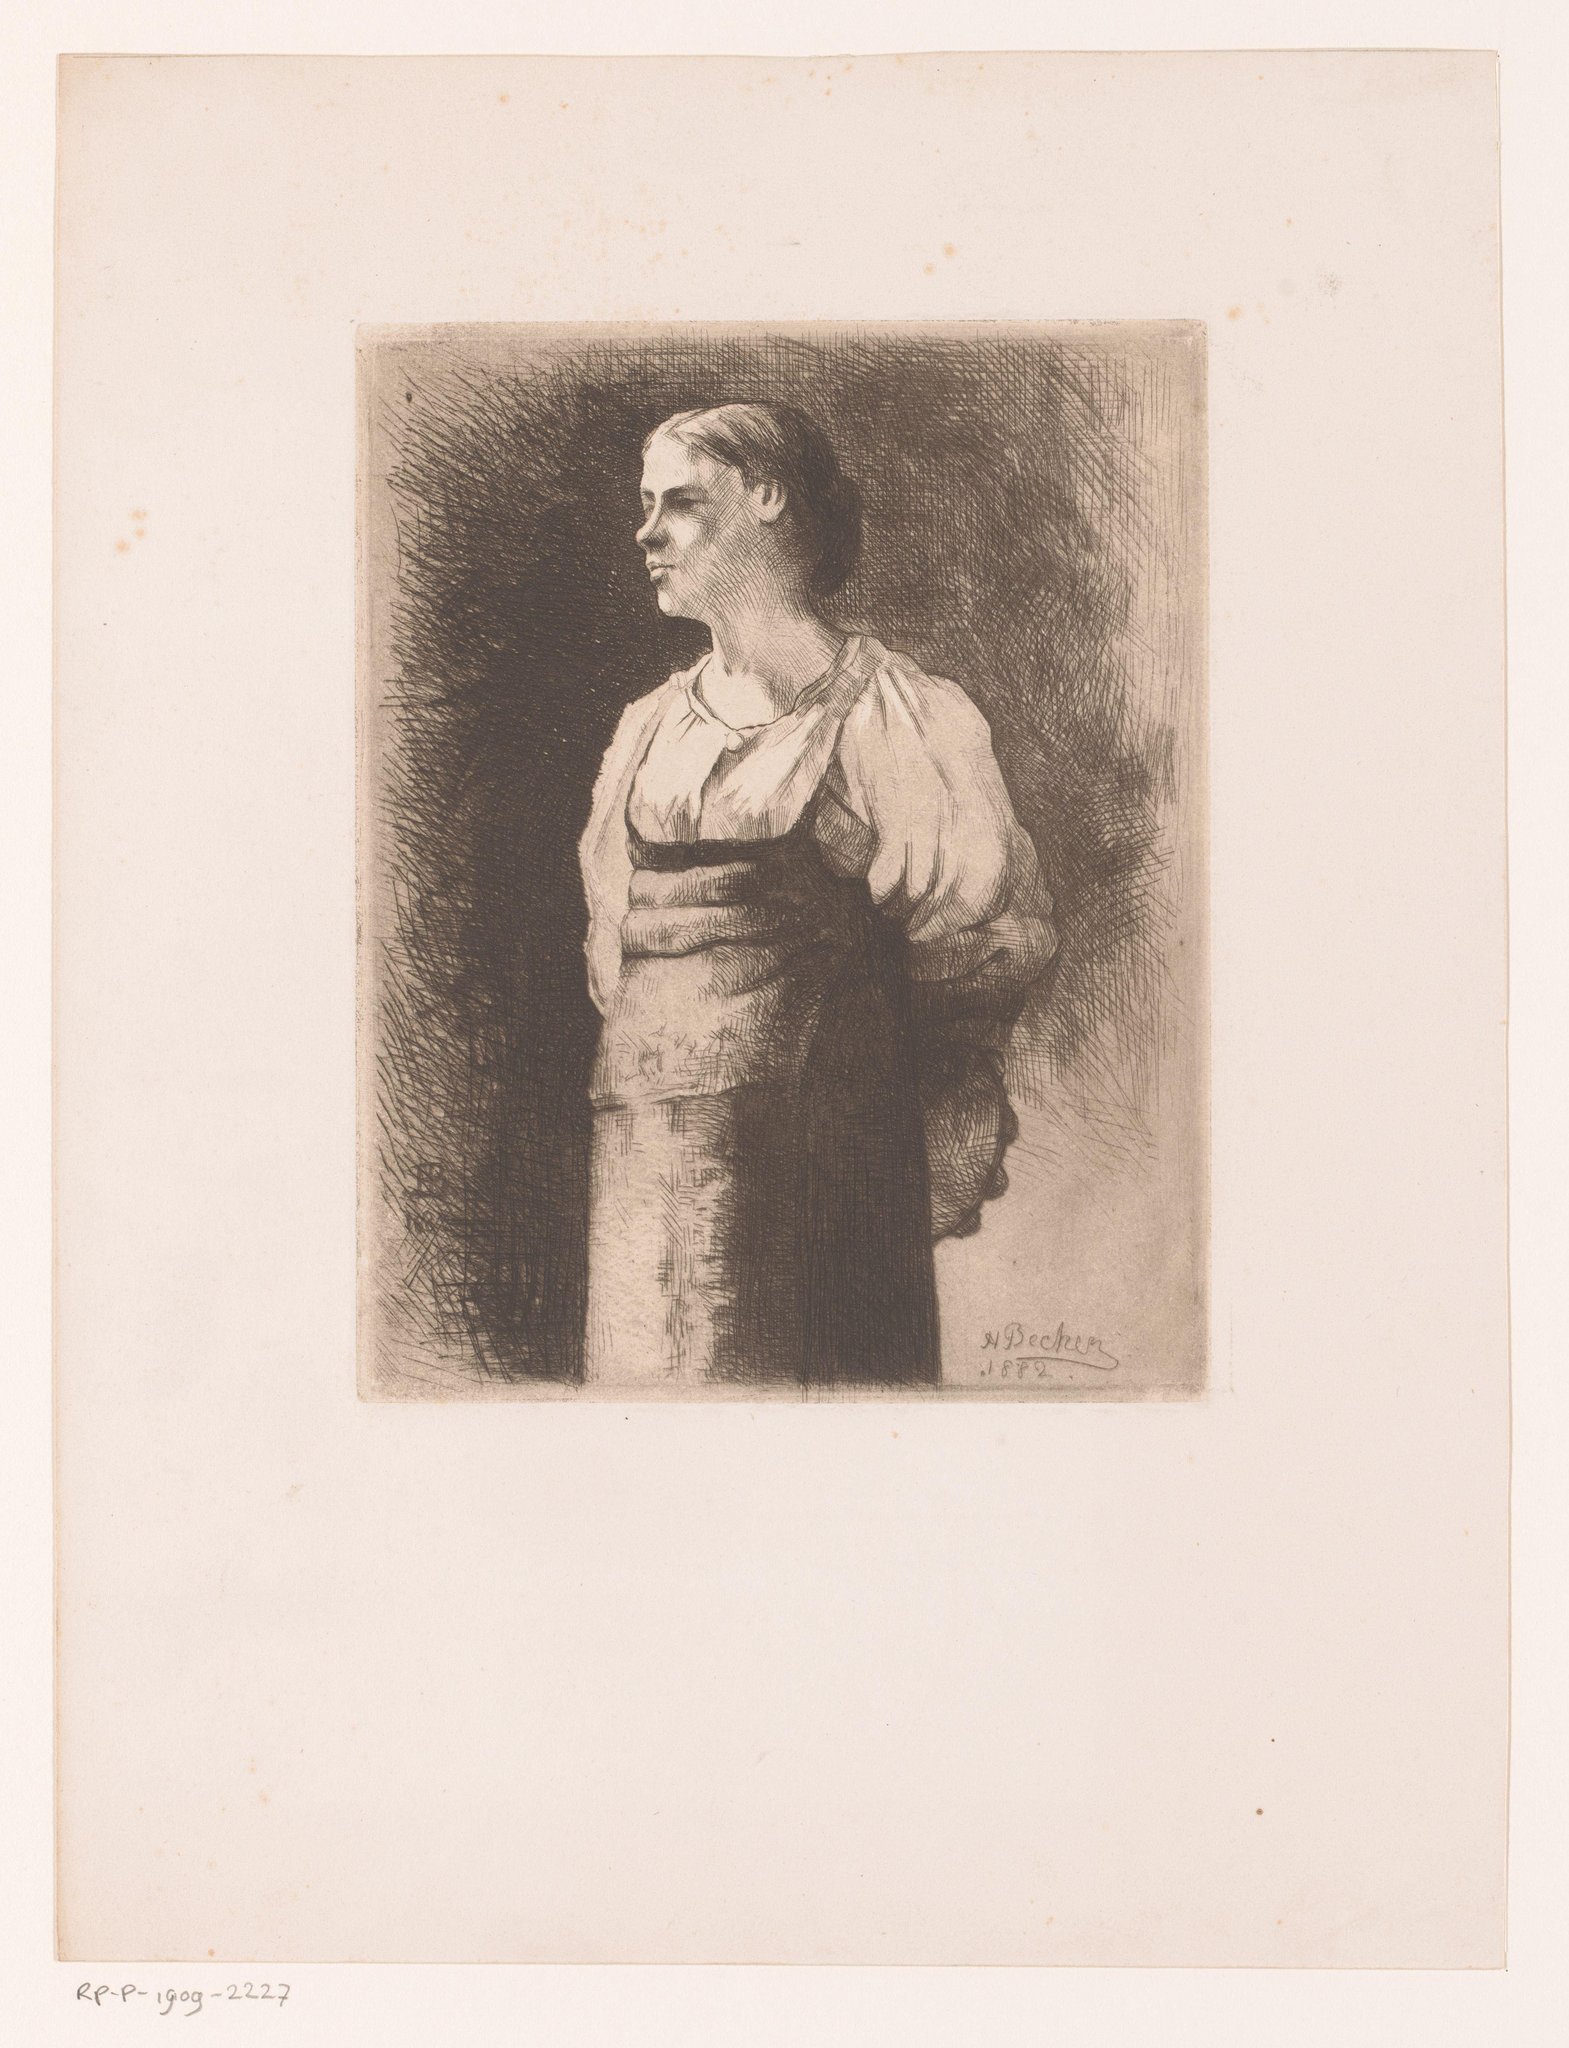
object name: print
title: Jonge vrouw met tamboerijn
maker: h. becker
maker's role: print maker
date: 1882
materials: paper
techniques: etching, intaglio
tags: tambourine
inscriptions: collector's mark: Lugt 2228